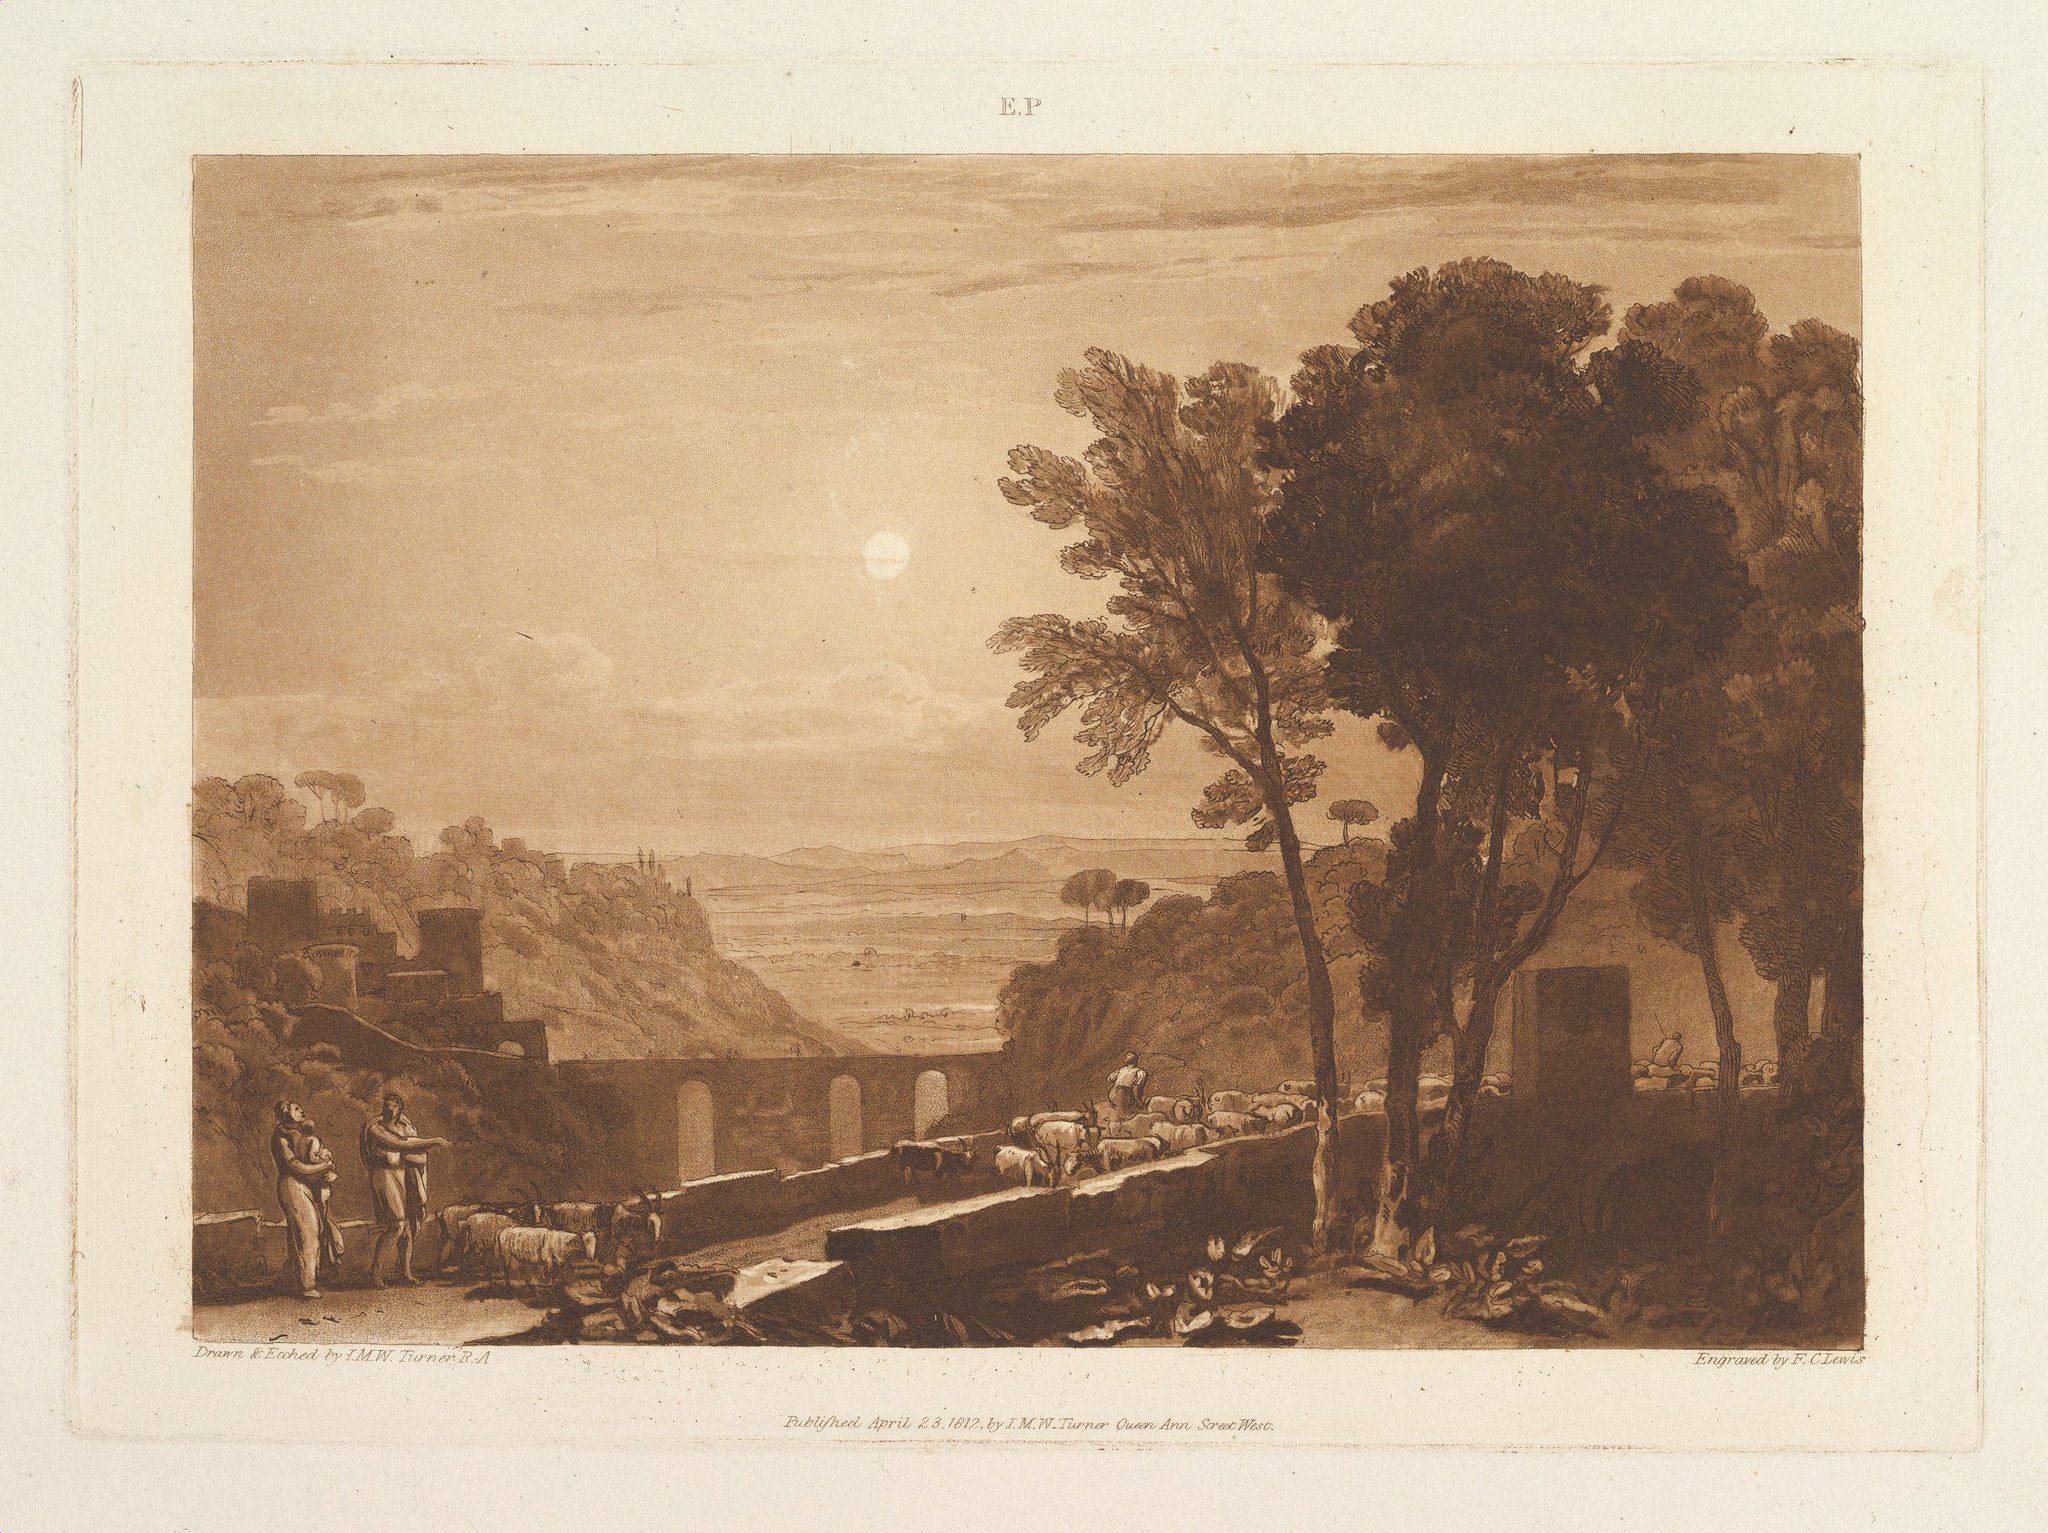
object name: print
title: The Bridge and Goats, part IX, plate 43 from "Liber Studiorum"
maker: joseph mallord william turner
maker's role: artist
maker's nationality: british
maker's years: 1775-1851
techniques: aquatint, etching, mezzotint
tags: bridges,goats,trees